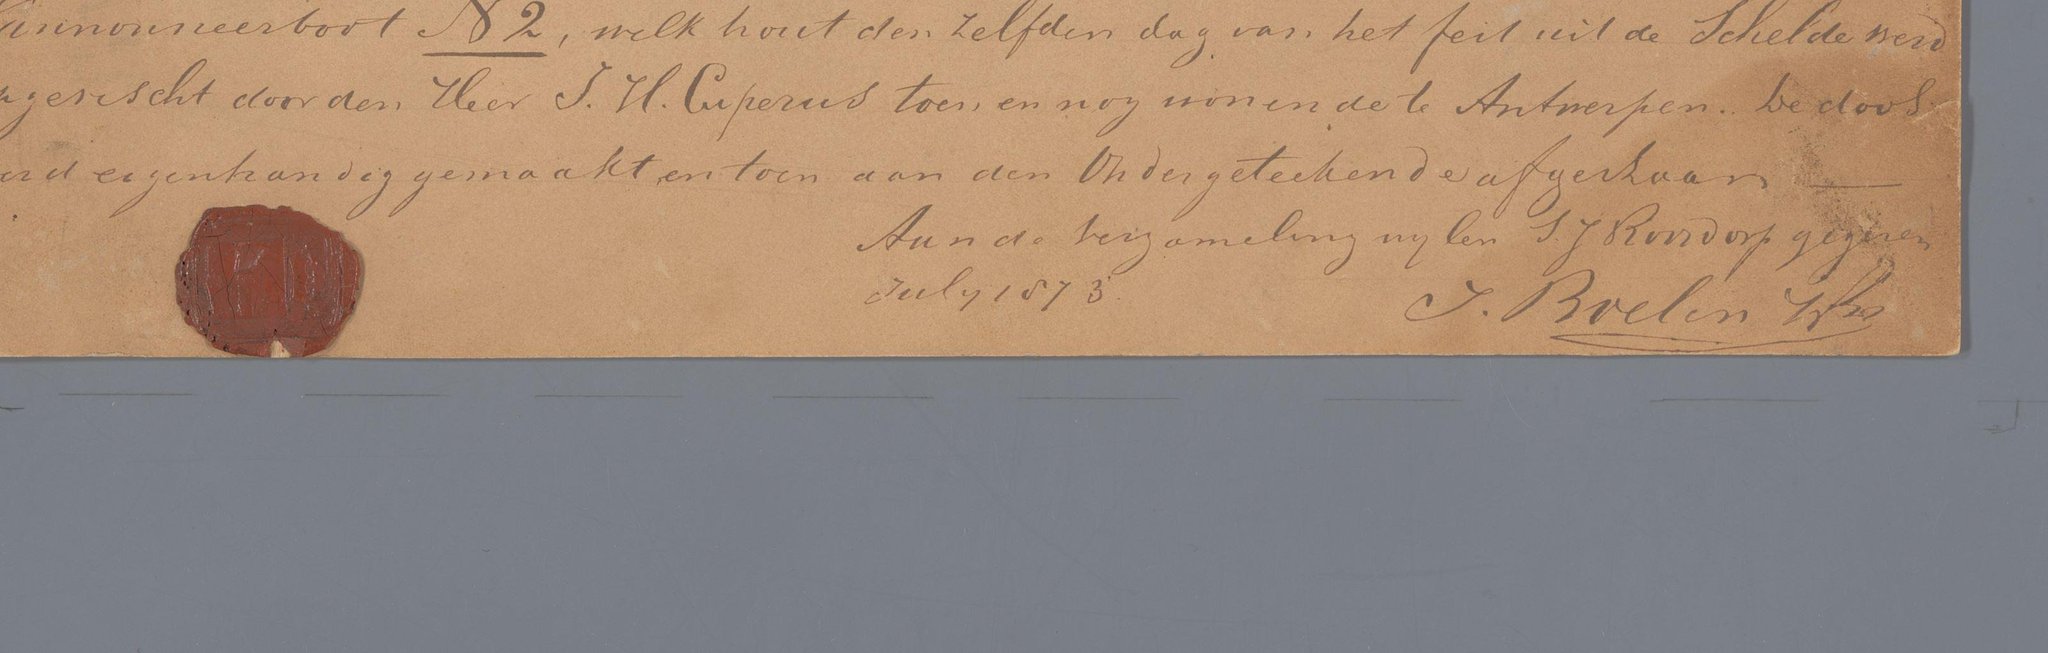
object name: verklaring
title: Verklaring van herkomst van het kistje vervaardigd van het hout van de kanonneerboot No. 2 van J.C.J. van Speyk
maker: j. boelen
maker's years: 1810-1890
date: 1807-1873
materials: cardboard, ink, paper, red lacquer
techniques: printing, pen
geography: netherlands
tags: amsterdam, antwerp, jan van speyk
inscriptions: inscription: ‘De Ondergeteekende verklaart voor echt en waar dat de doos waarinliggen de overblijfselen van J.C.J. van Speyk zich bevinden, is gemaakt van het hout van de Kannonneerboot N2, welk hout den zelfden dag van het feit uit de Schelde werd opgevischt door den Heer I.H. Cuperus toen en nog wonende te Antwerpen. De doos werd eigenhandig gemaakt en toen aan den Ondergeteekende afgestaan__ Aan de verzameling wijlen S.J. Roosdorp gegeven July 1873 J. Boelen Jkzn’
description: Volgens de verklaring werd het hout op 5 februari 1831 door Cuperus uit de Schelde gevist. Hij maakte er eigenhandig het kistje van, die hij naar Boelen opstuurde. Boelen schonk op zijn beurt het object aan de verzameling van 'wijlen S.J. Roosdorp' in 1873.